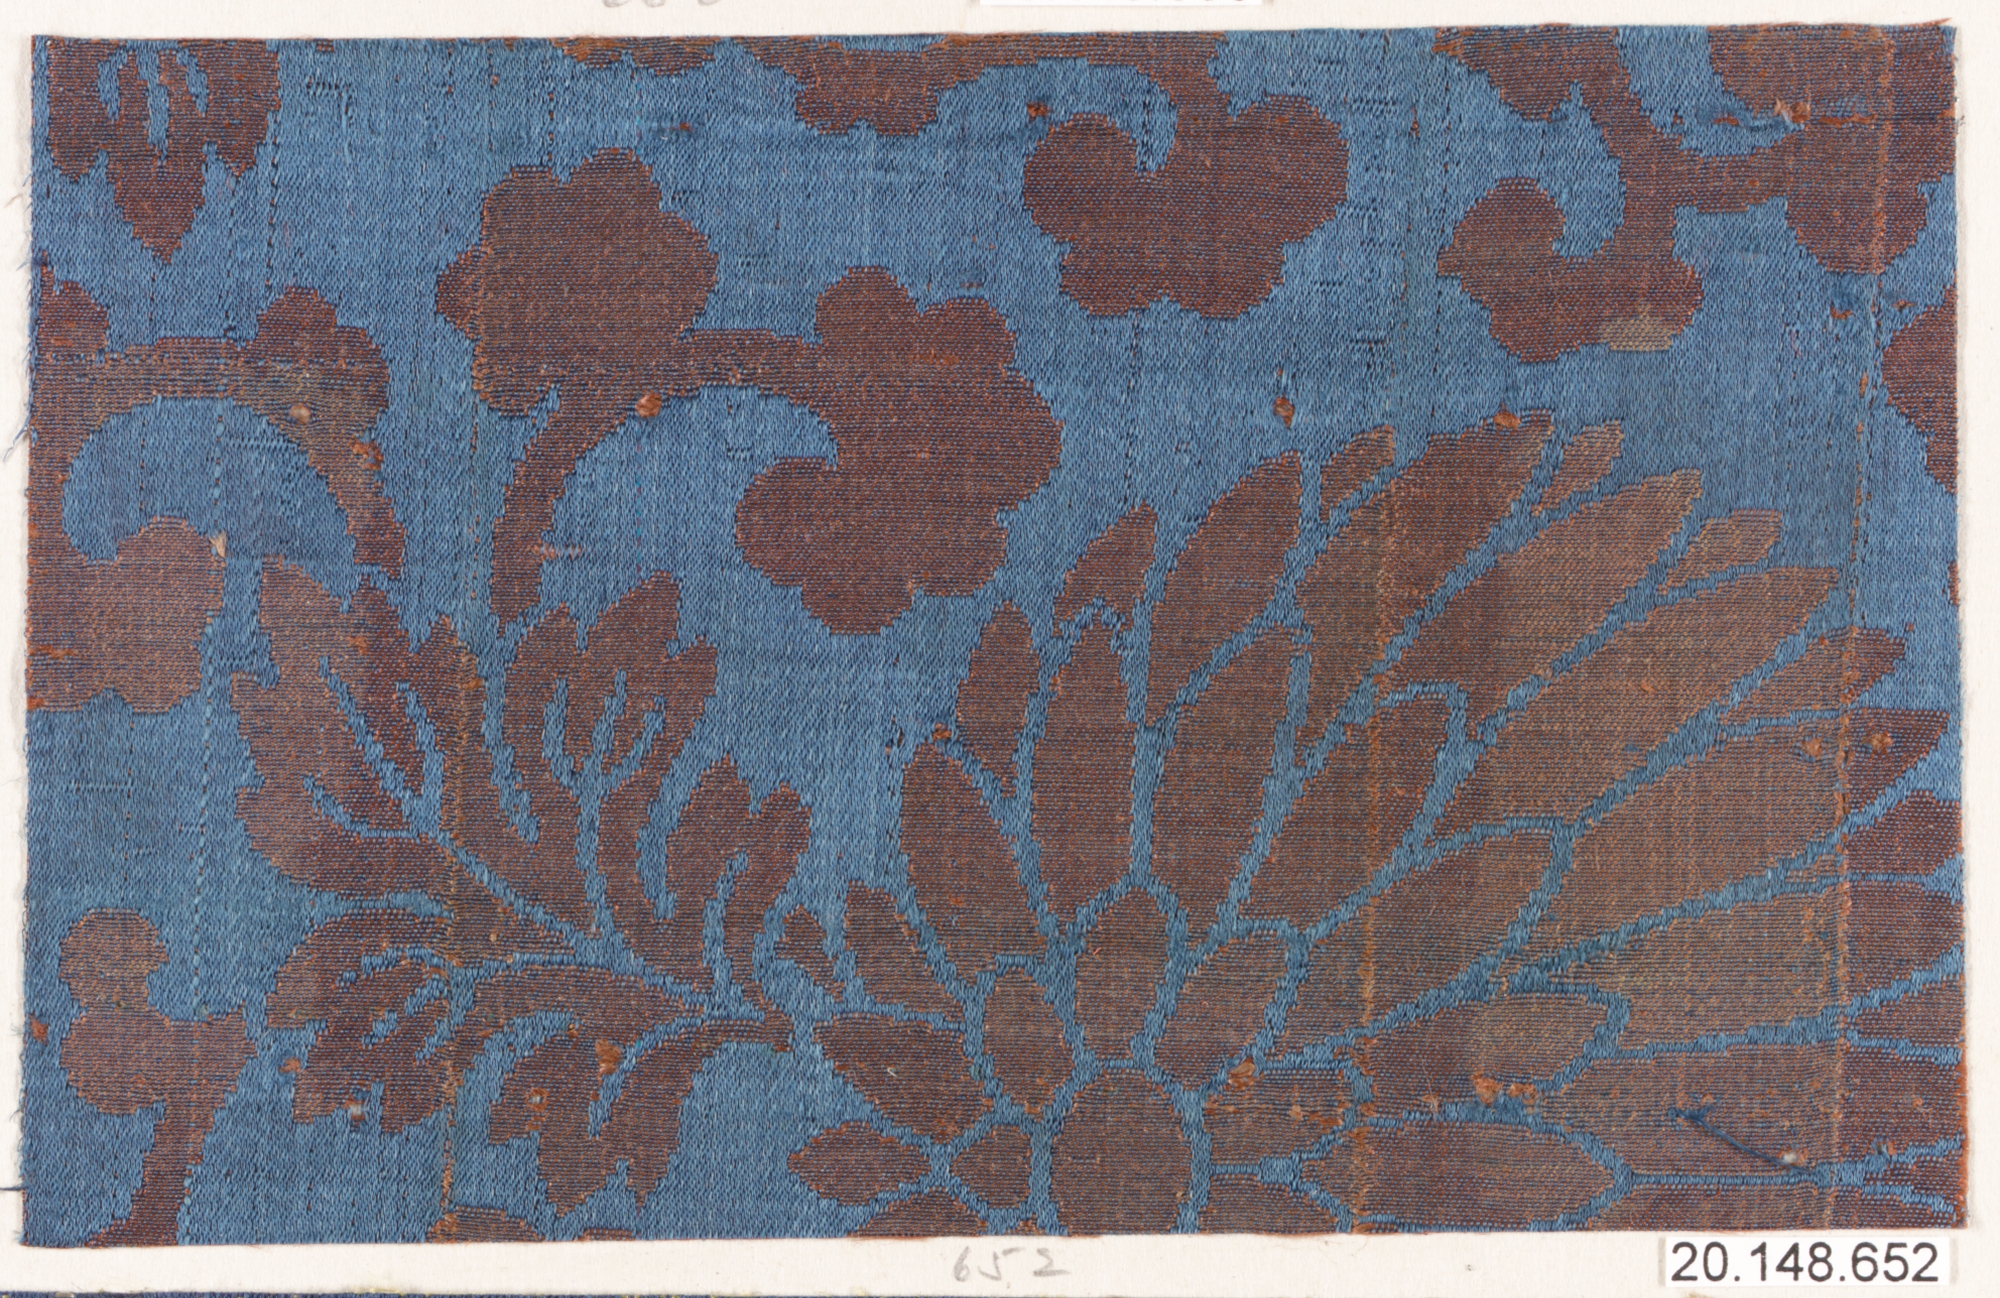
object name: piece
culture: japanese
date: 1701-1800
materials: silk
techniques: compound weave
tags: flowers,leaves